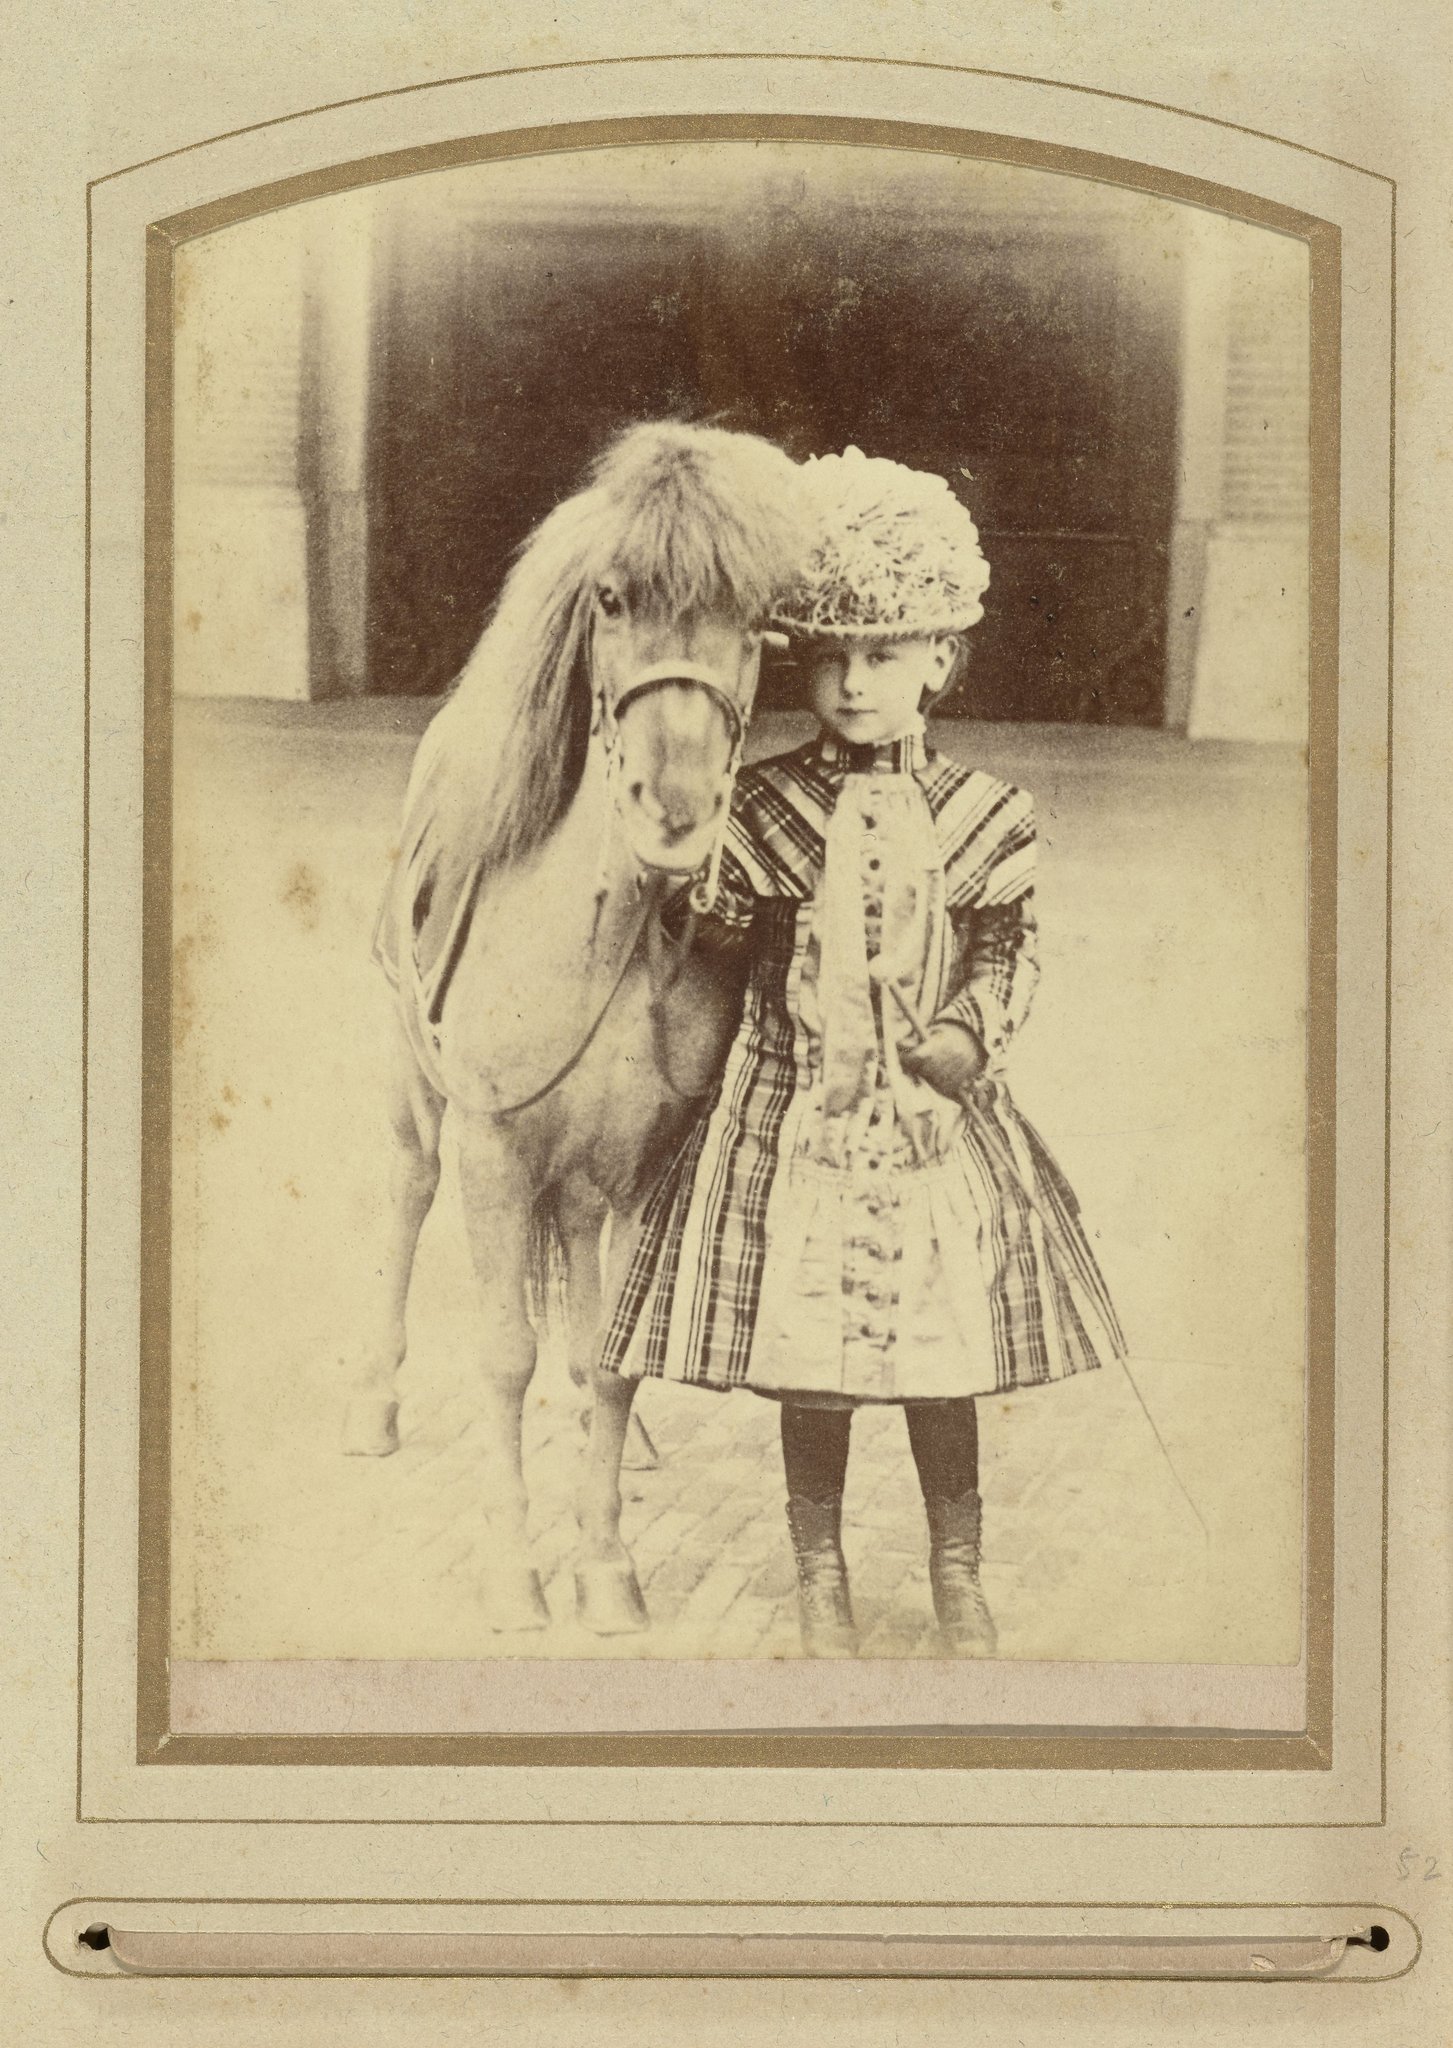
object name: carte de visite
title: Portret van prinses Wilhelmina met een pony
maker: richard kameke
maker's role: fotograaf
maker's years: 1847-1898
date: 1887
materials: paper, photographic support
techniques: photography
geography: netherlands